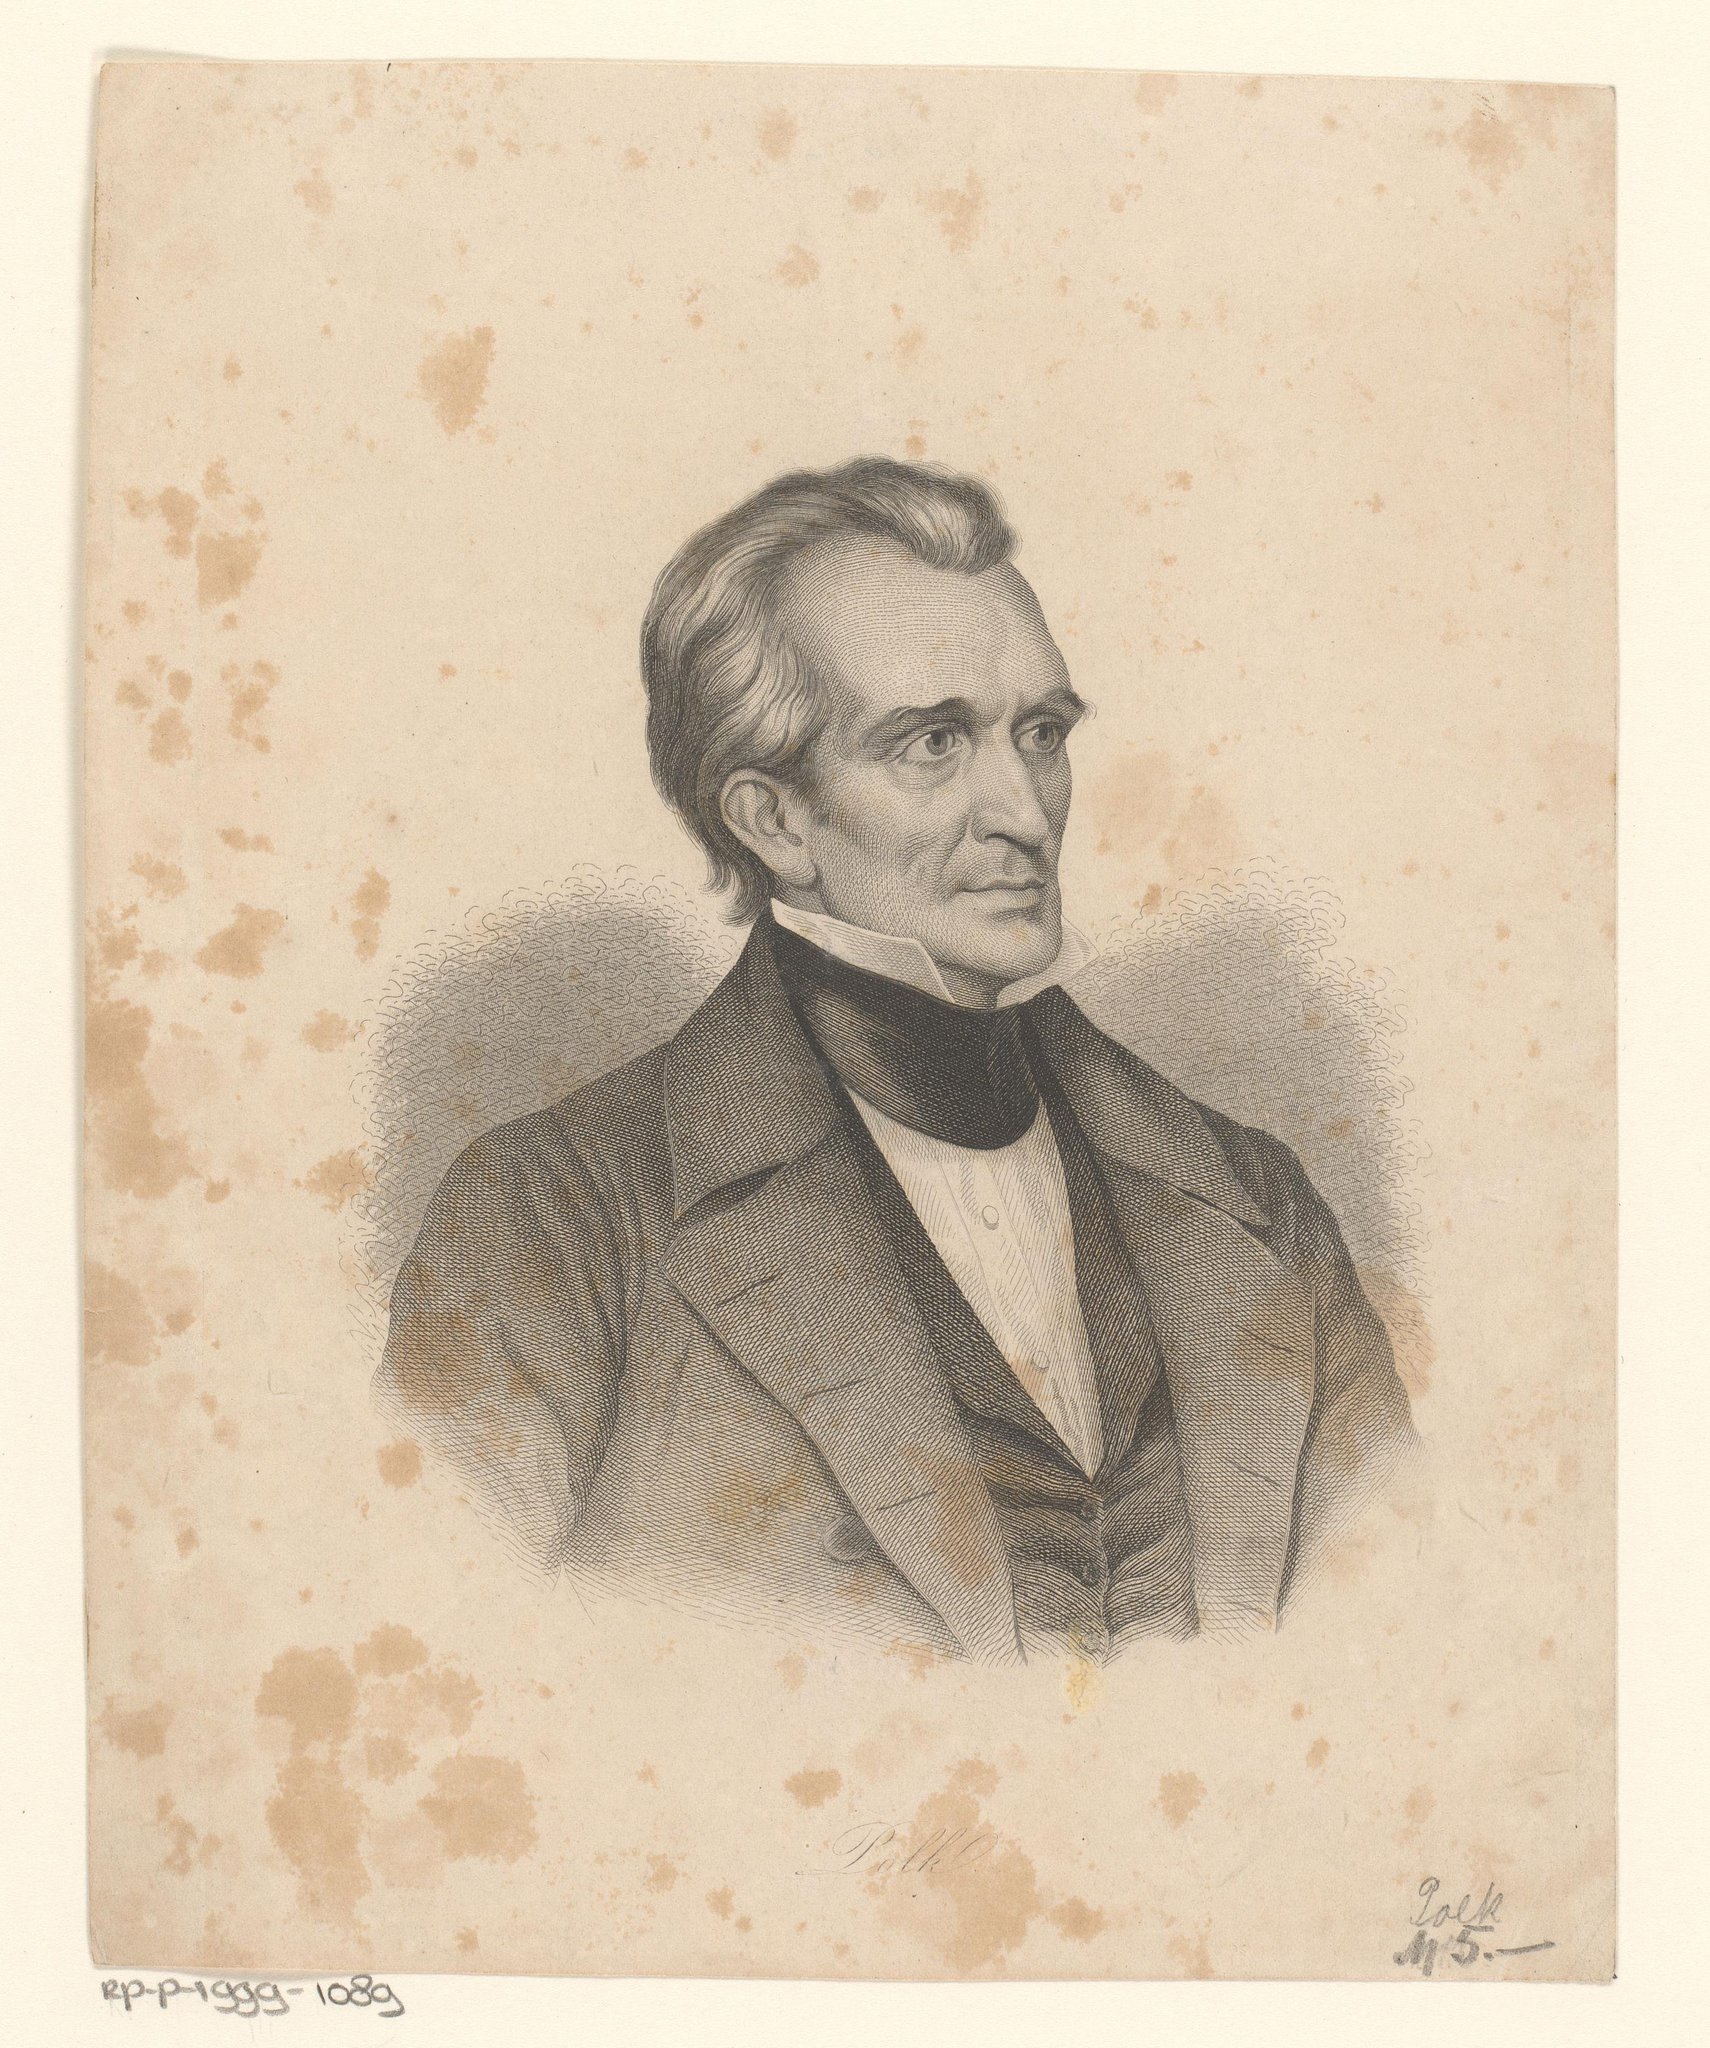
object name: print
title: Portret van James Knox Polk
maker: Anonymous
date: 1835-1899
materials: paper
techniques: engraving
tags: president ~ head of republic, historical persons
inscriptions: collector's mark: Lugt 2760, collector's mark: Lugt 2228, stamp: ‘Franz Rade[...]’